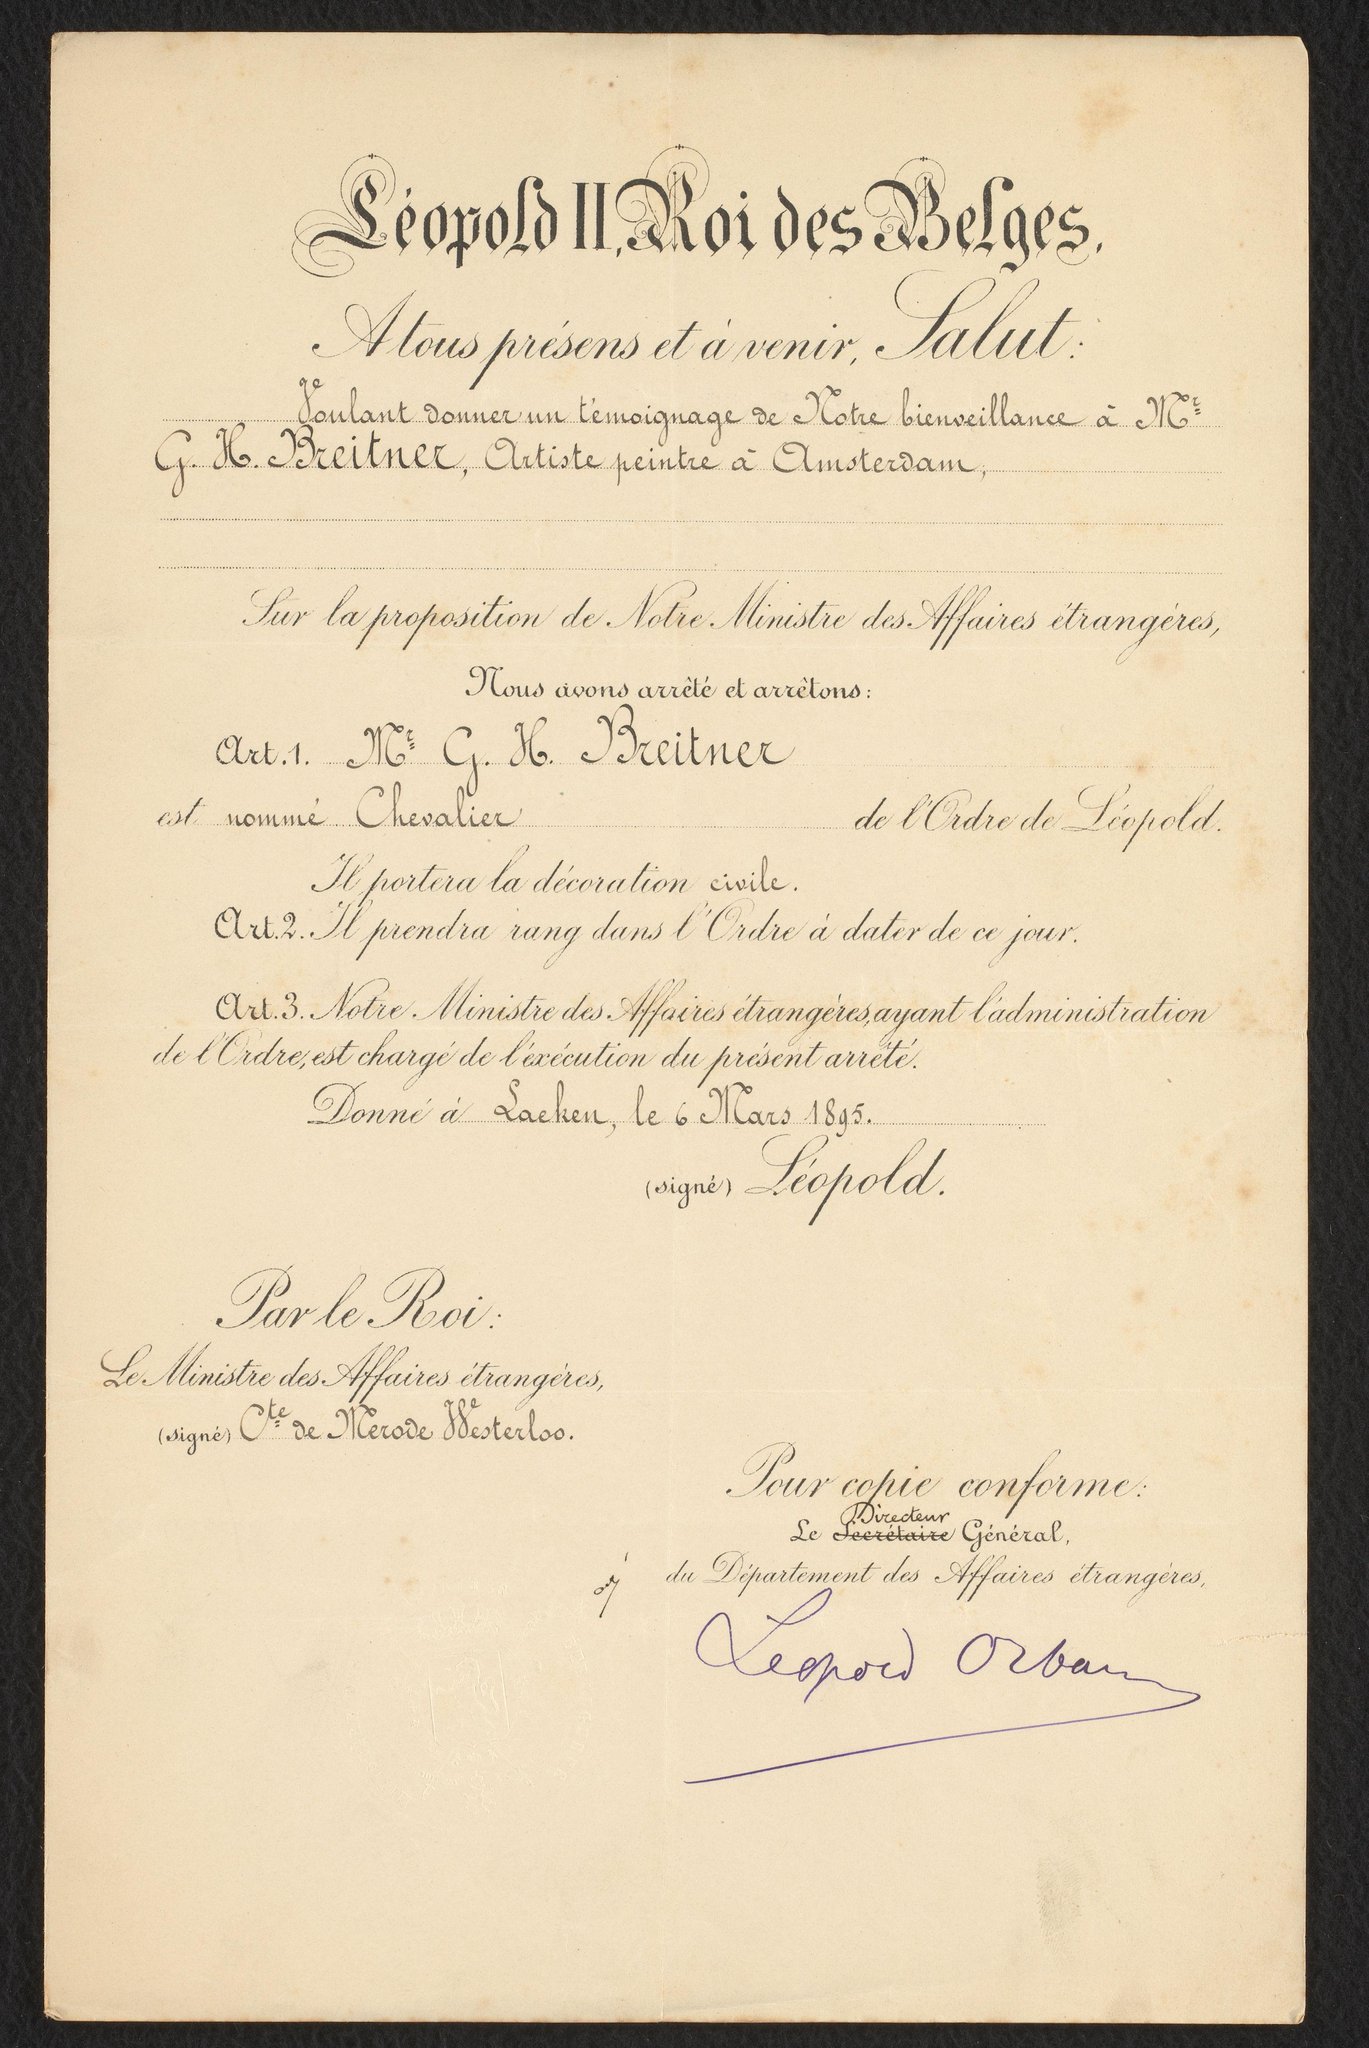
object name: document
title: Document bevattende de benoeming van George Hendrik Breitner tot ridder in de Orde van Leopold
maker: Anonymous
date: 1895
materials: ink, paper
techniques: blind stamped, letterpress printing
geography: brussels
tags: rotterdam, amsterdam, painter, print maker, draughtsman, george hendrik breitner, distribution of awards ~ art contest